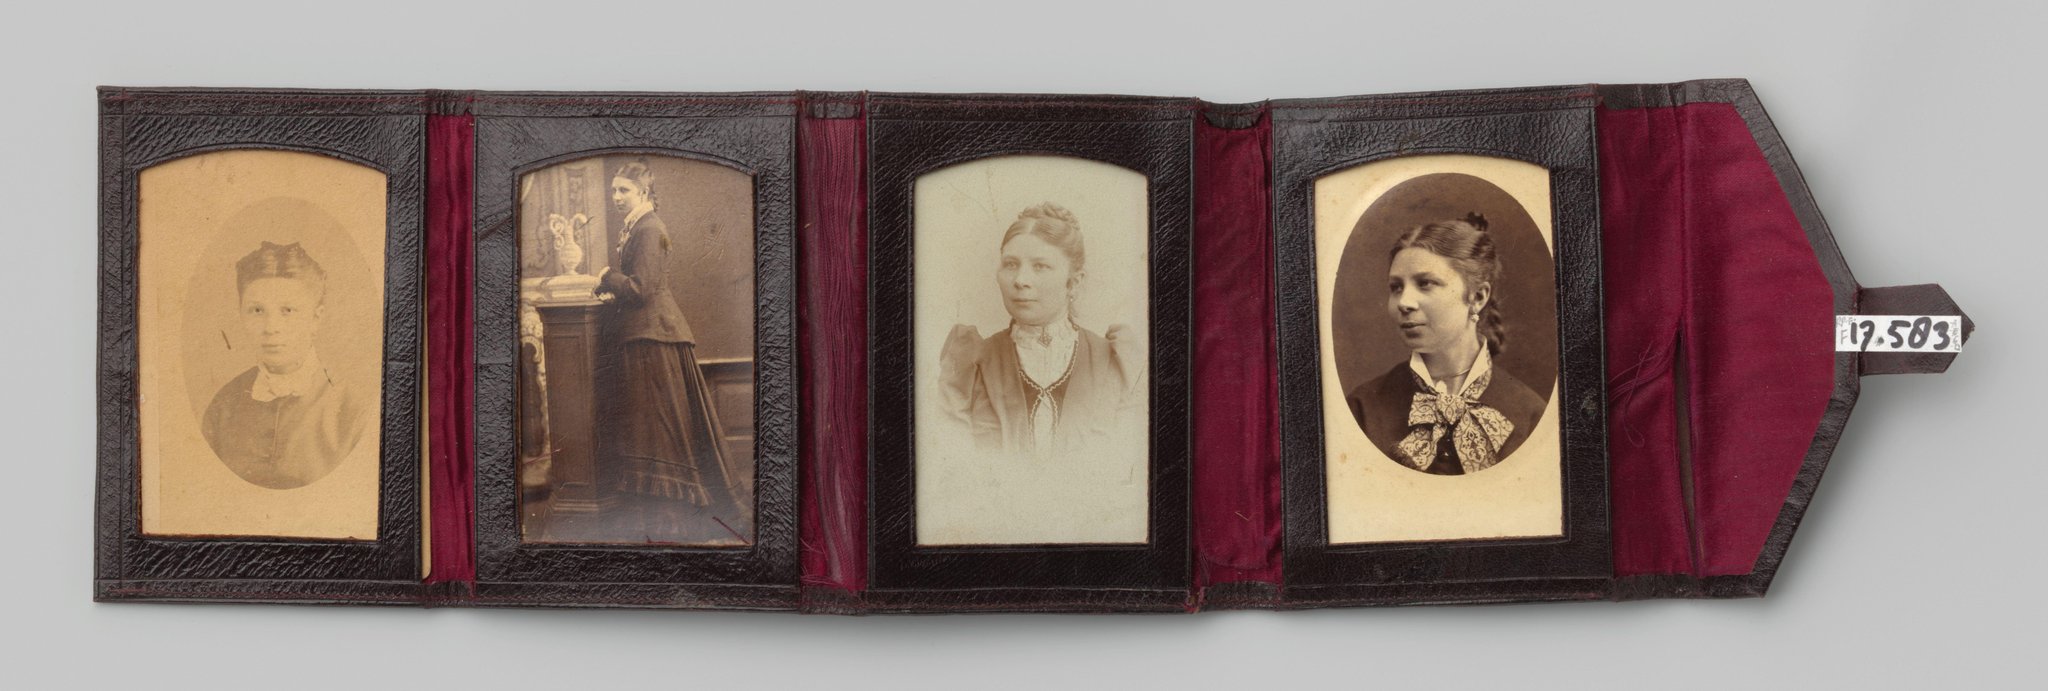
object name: photograph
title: Portefeuille met vier portretten van een onbekende vrouw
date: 1865-1896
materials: cardboard, leather, paper, textile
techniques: albumen print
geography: haarlem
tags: adult woman, haarlem